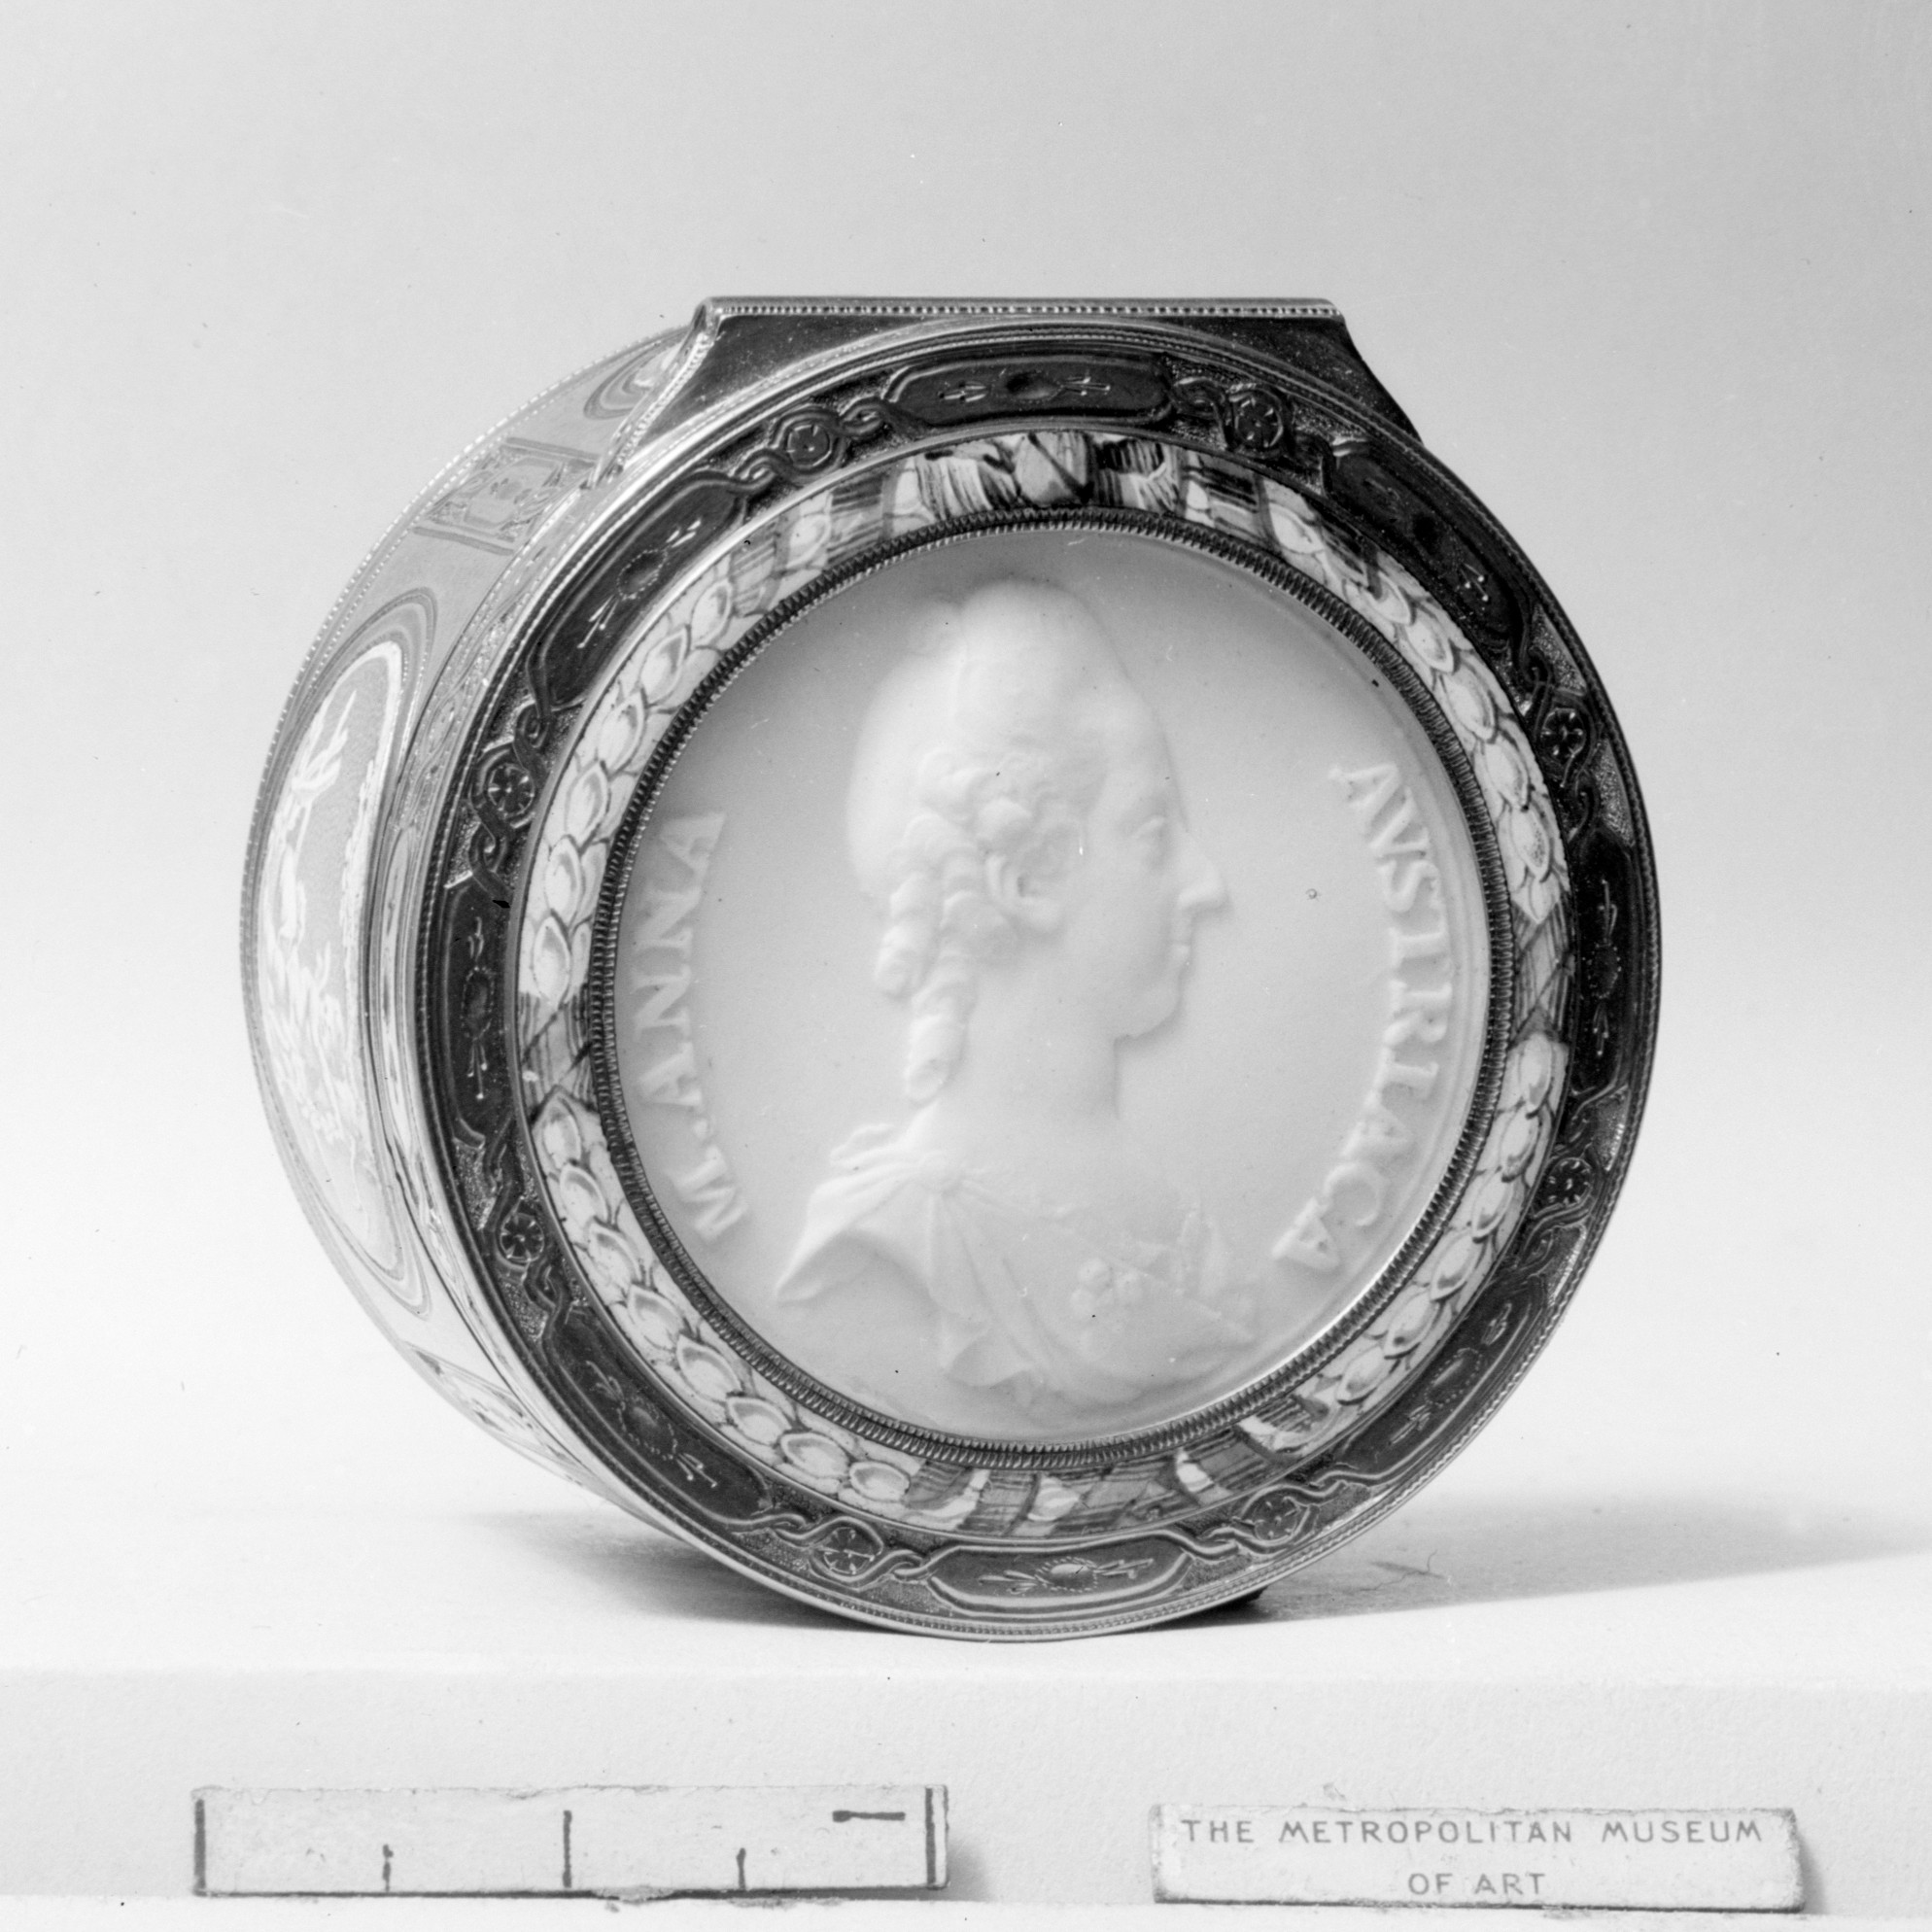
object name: snuffbox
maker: philippe ernst schindler (the younger)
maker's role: artist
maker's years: 1723-1793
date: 1766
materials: enamel, gold, porcelain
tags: profiles,women